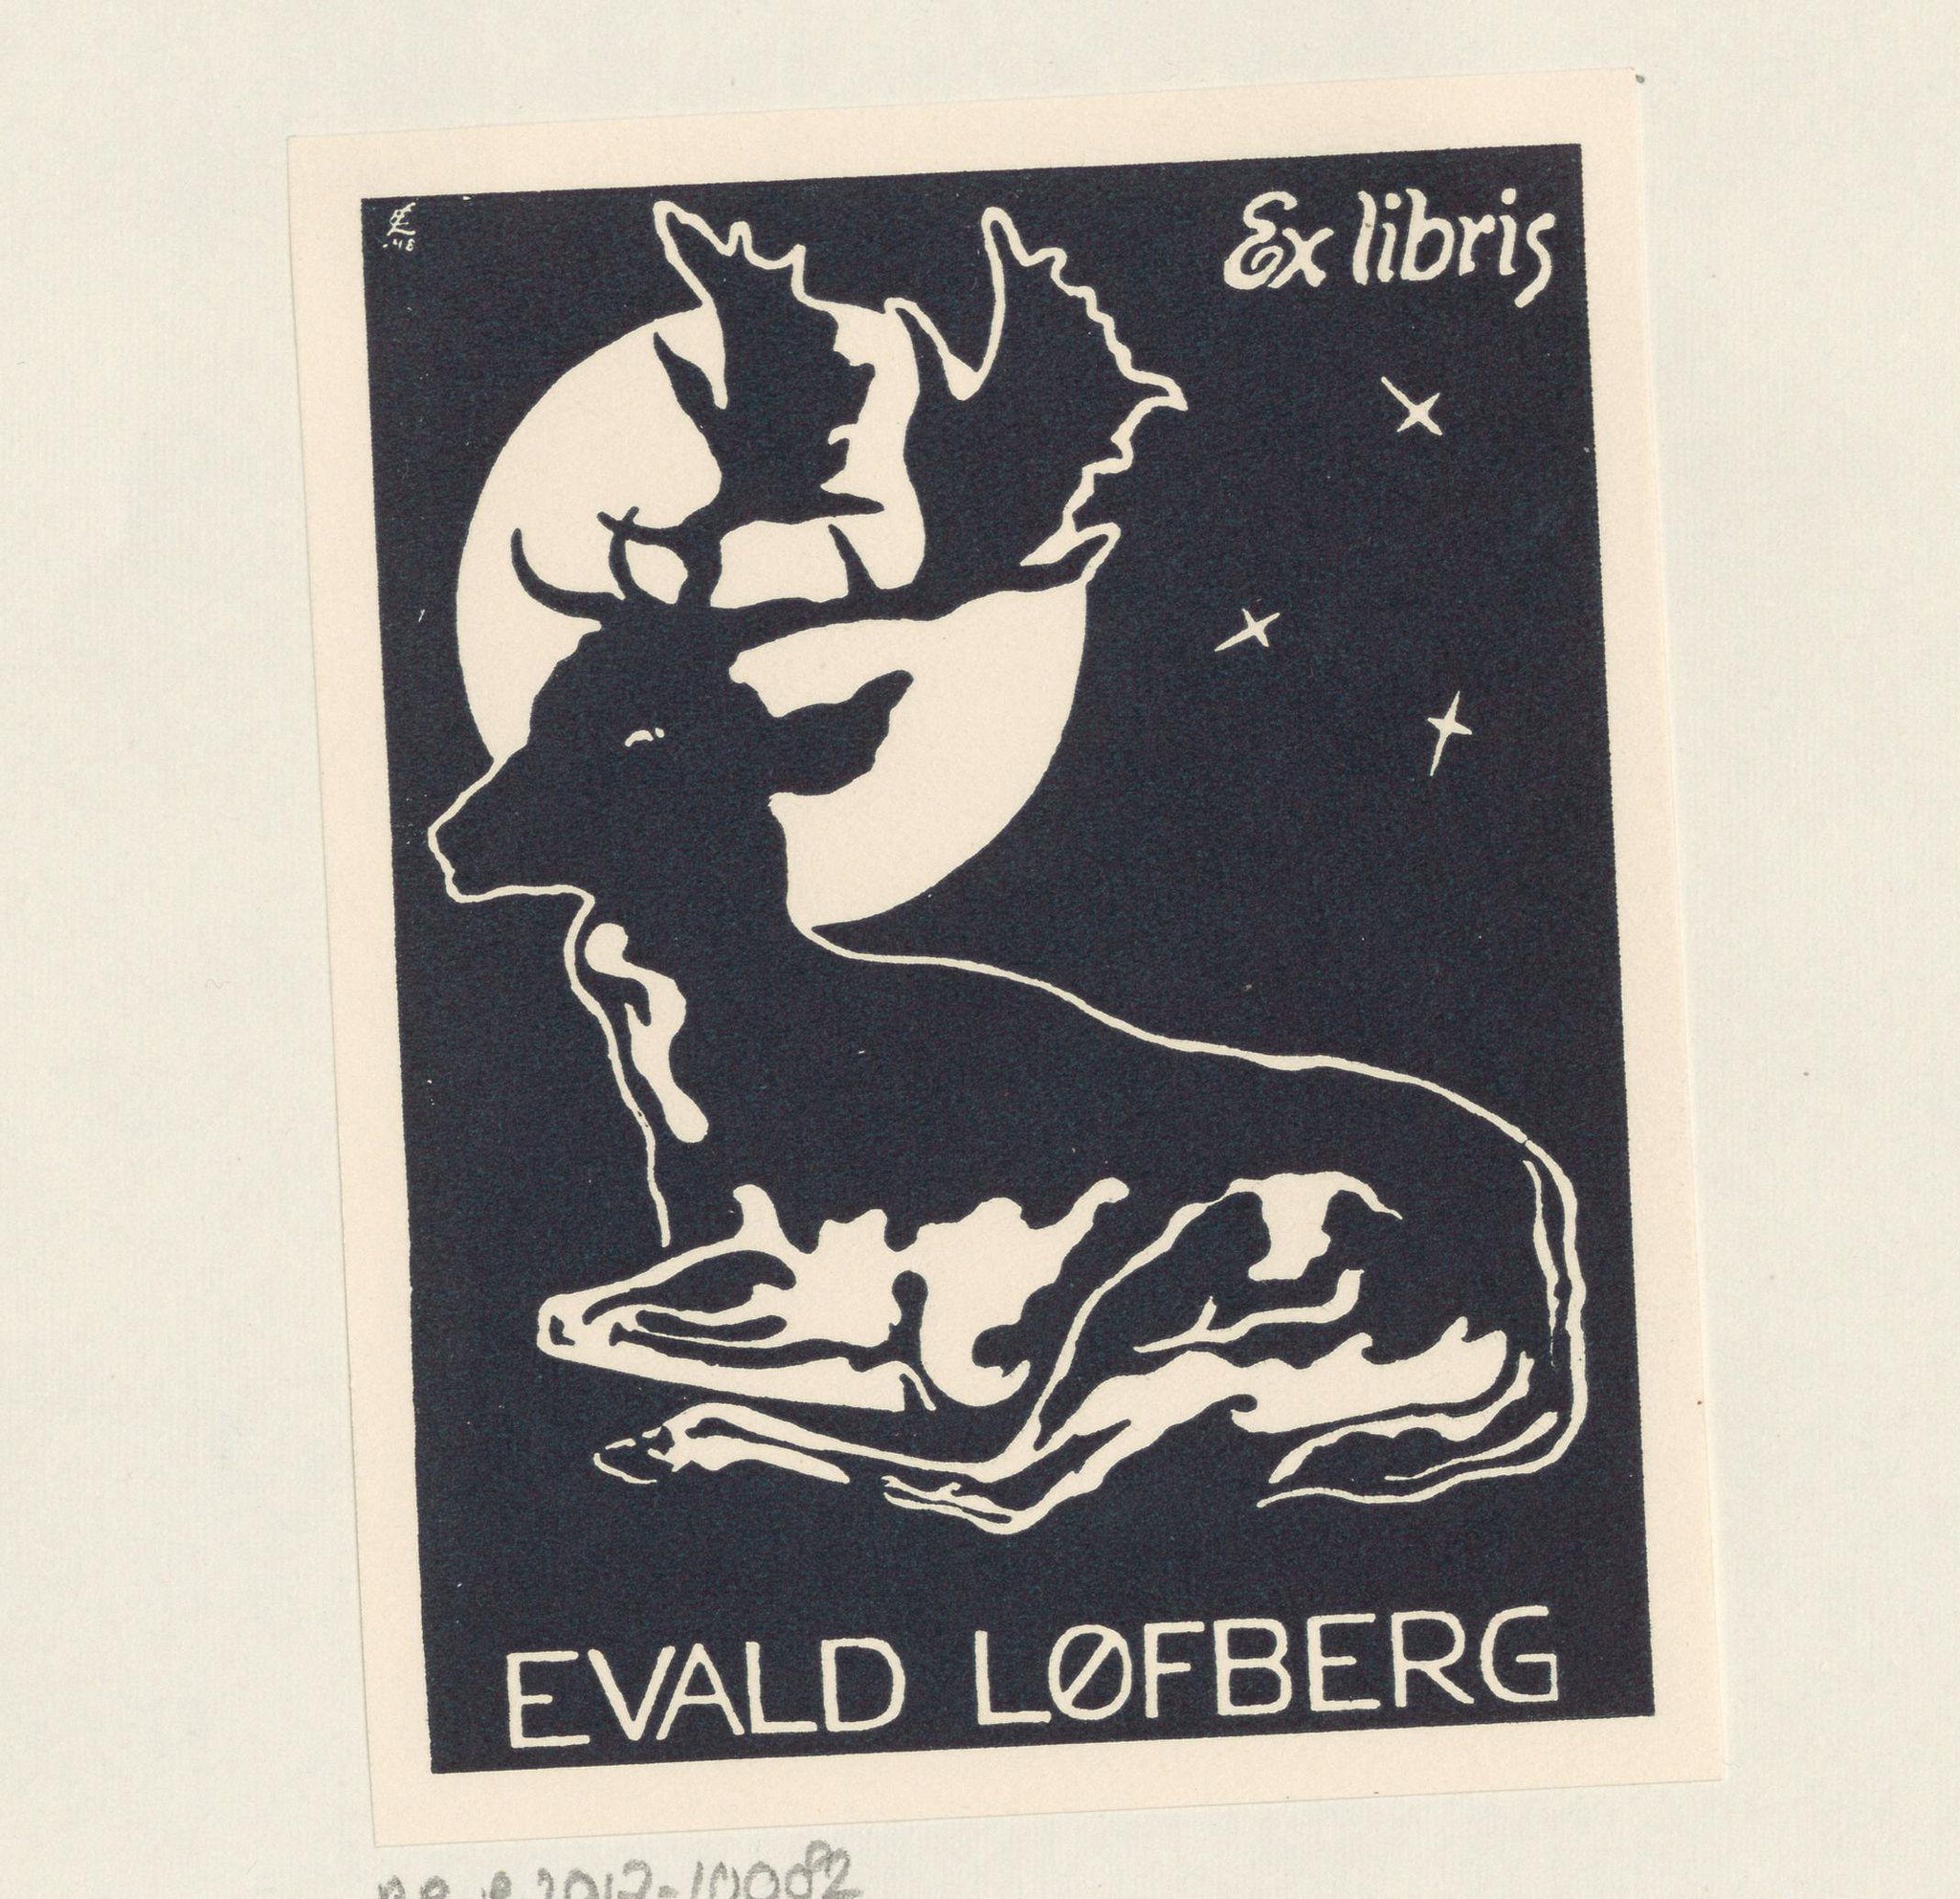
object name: bookplate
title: Ex libris van Evald Løfberg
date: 1948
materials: paper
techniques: printing block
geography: denmark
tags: evald løfberg, full moon, hoofed animals: stag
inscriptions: date